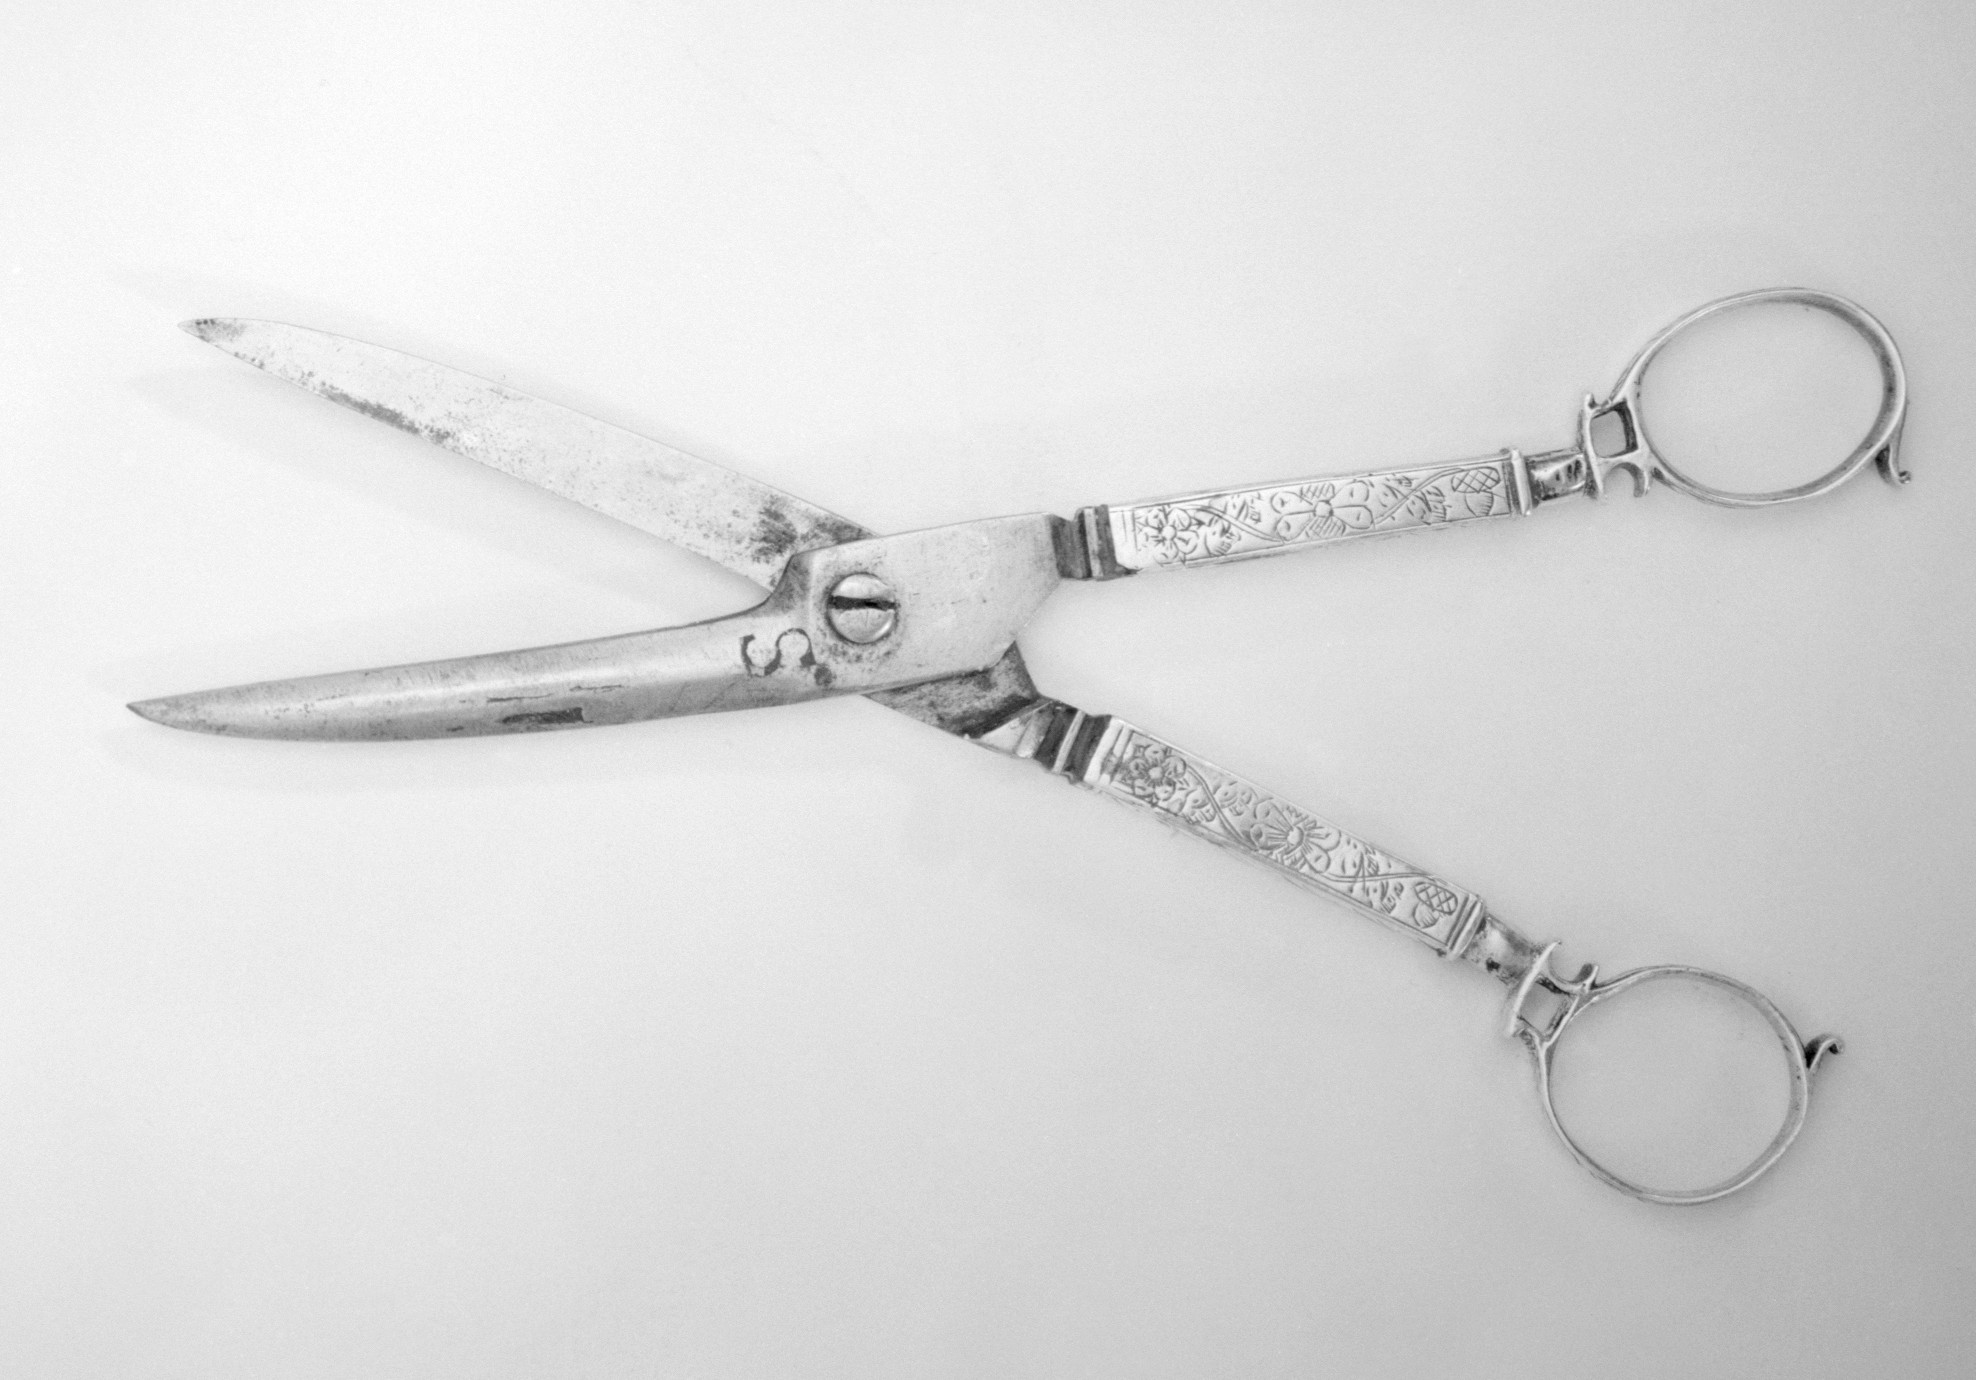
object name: scissors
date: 1636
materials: silver, steel